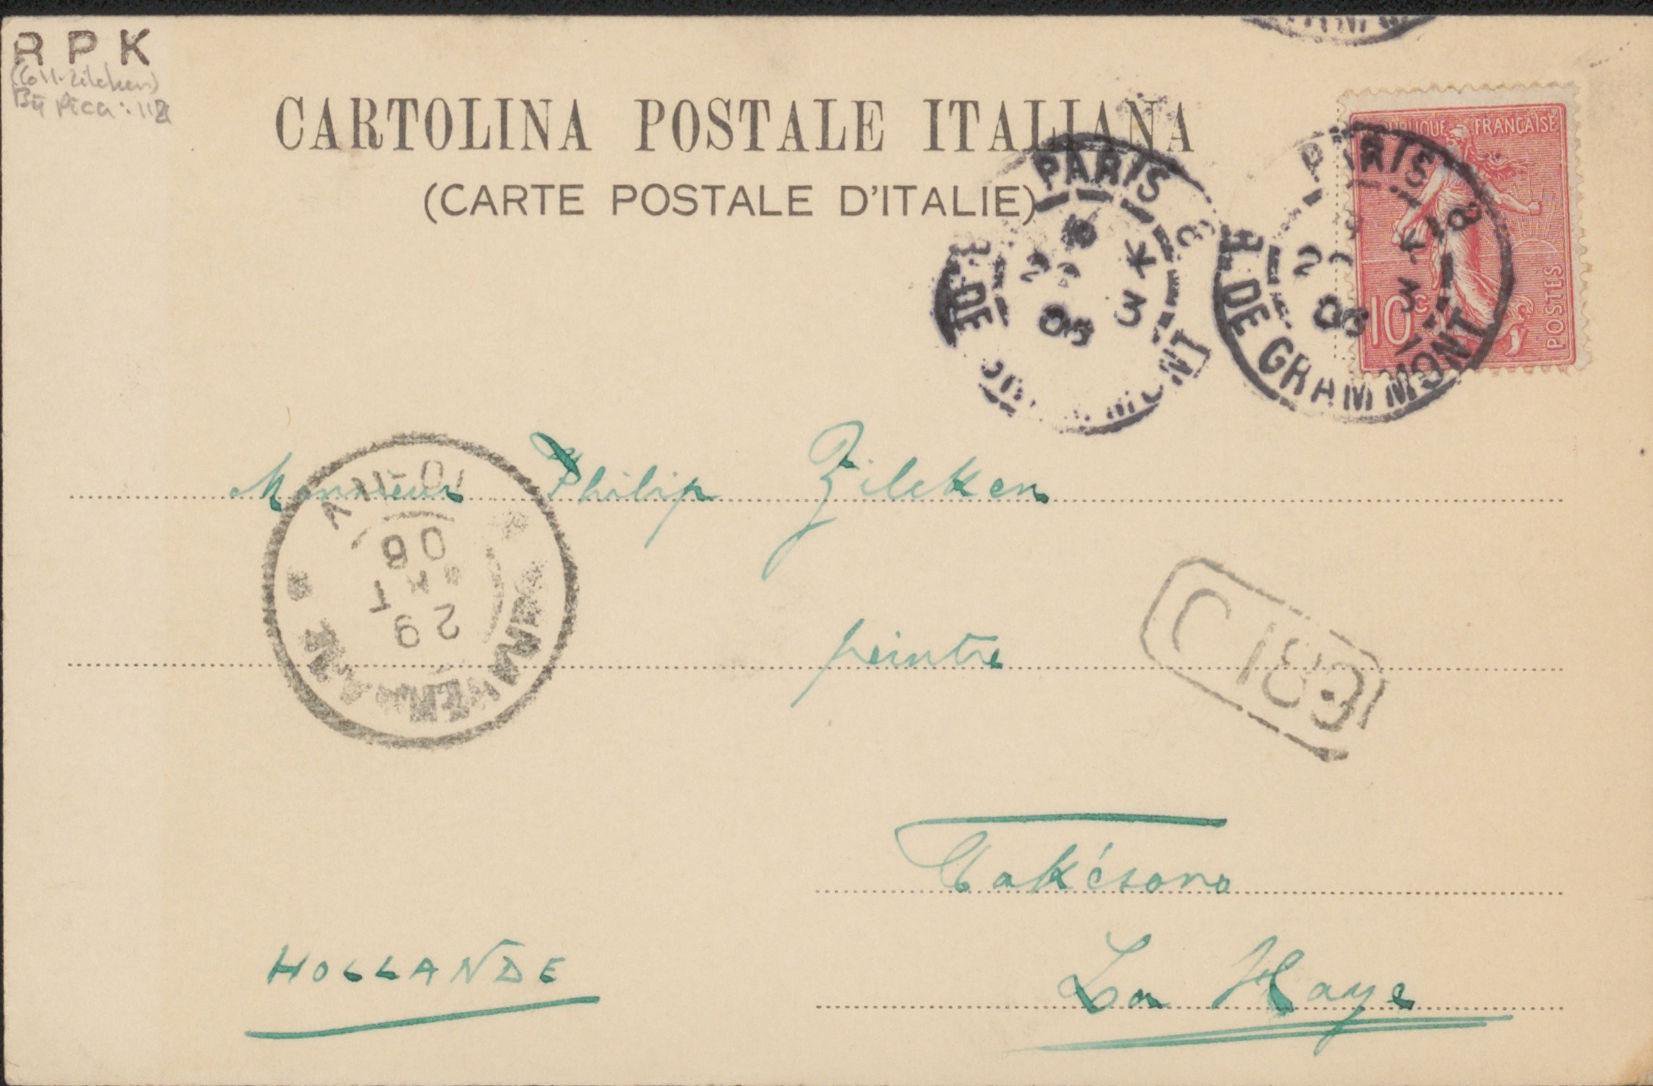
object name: postcard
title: Briefkaart aan Philip Zilcken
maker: vittorio pica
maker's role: criticus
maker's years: 1864-1930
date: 1906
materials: cardboard, ink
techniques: pen, printing, writing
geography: paris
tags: the hague, painter, draughtsman, philip zilcken, family life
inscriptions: collector's mark: ‘RPK’